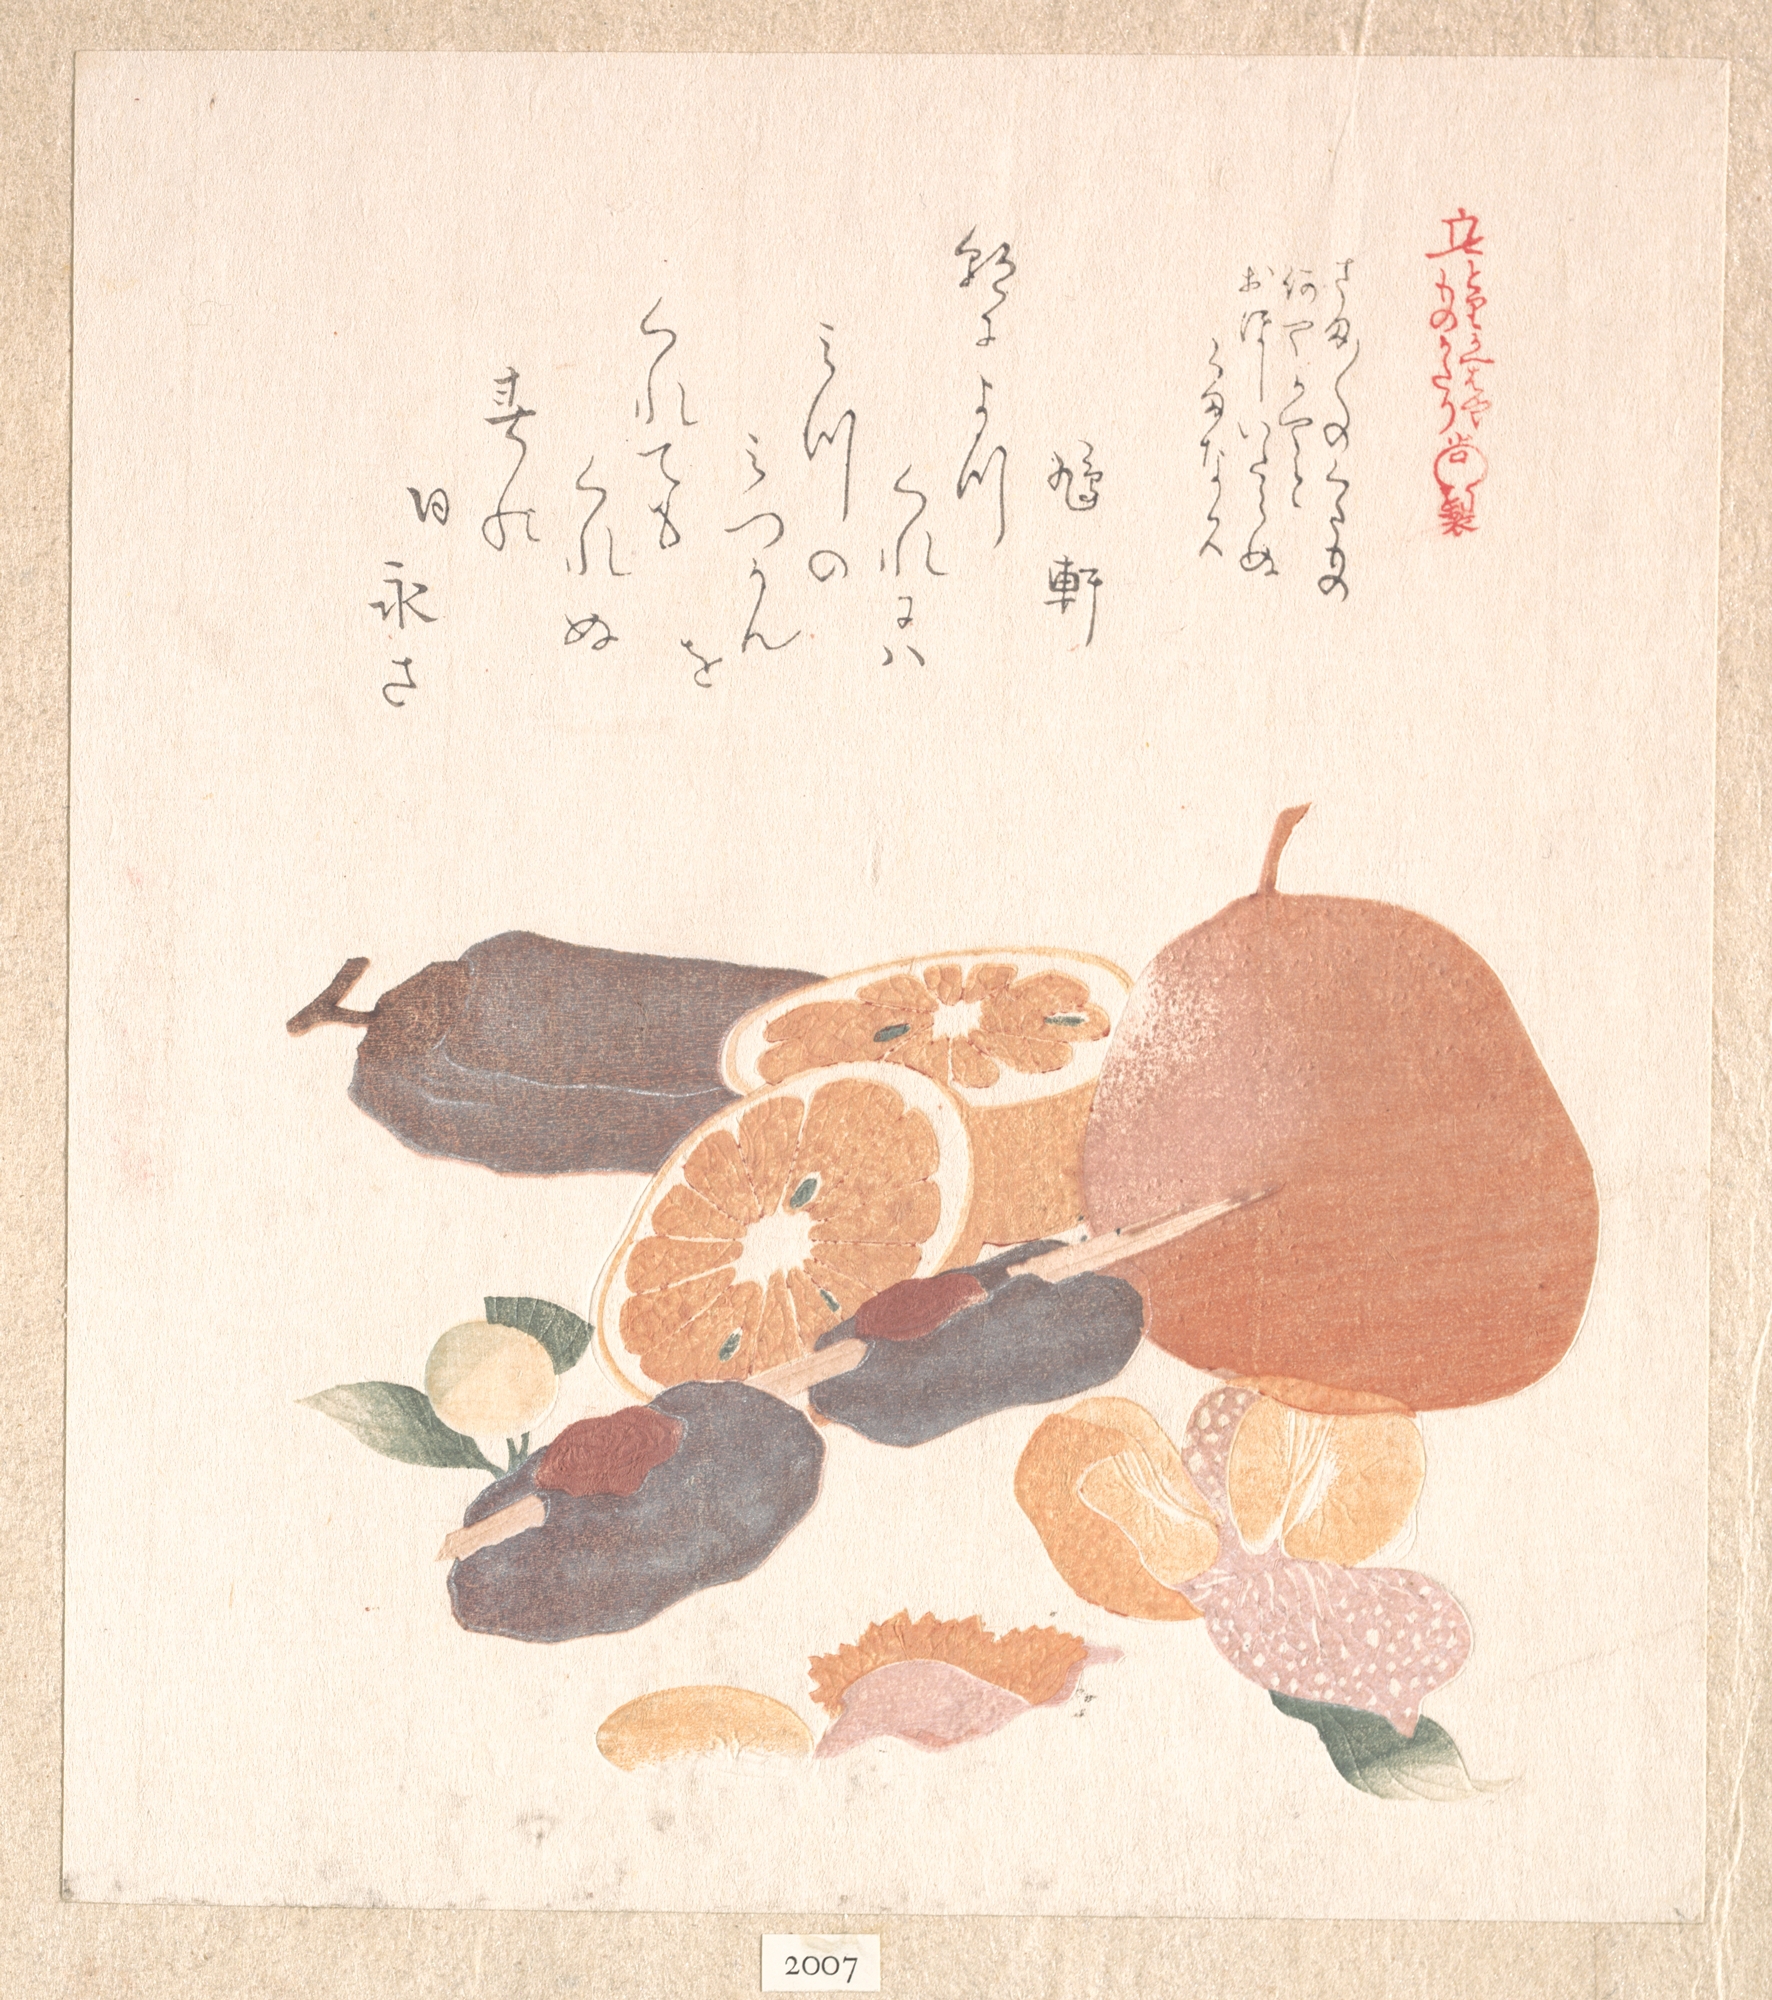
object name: print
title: Oranges and Dried Persimmons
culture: japanese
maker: kubo shunman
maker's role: artist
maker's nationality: japanese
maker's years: 1757-1820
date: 1801-1900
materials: ink, paper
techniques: surimono, woodblock print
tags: fruit